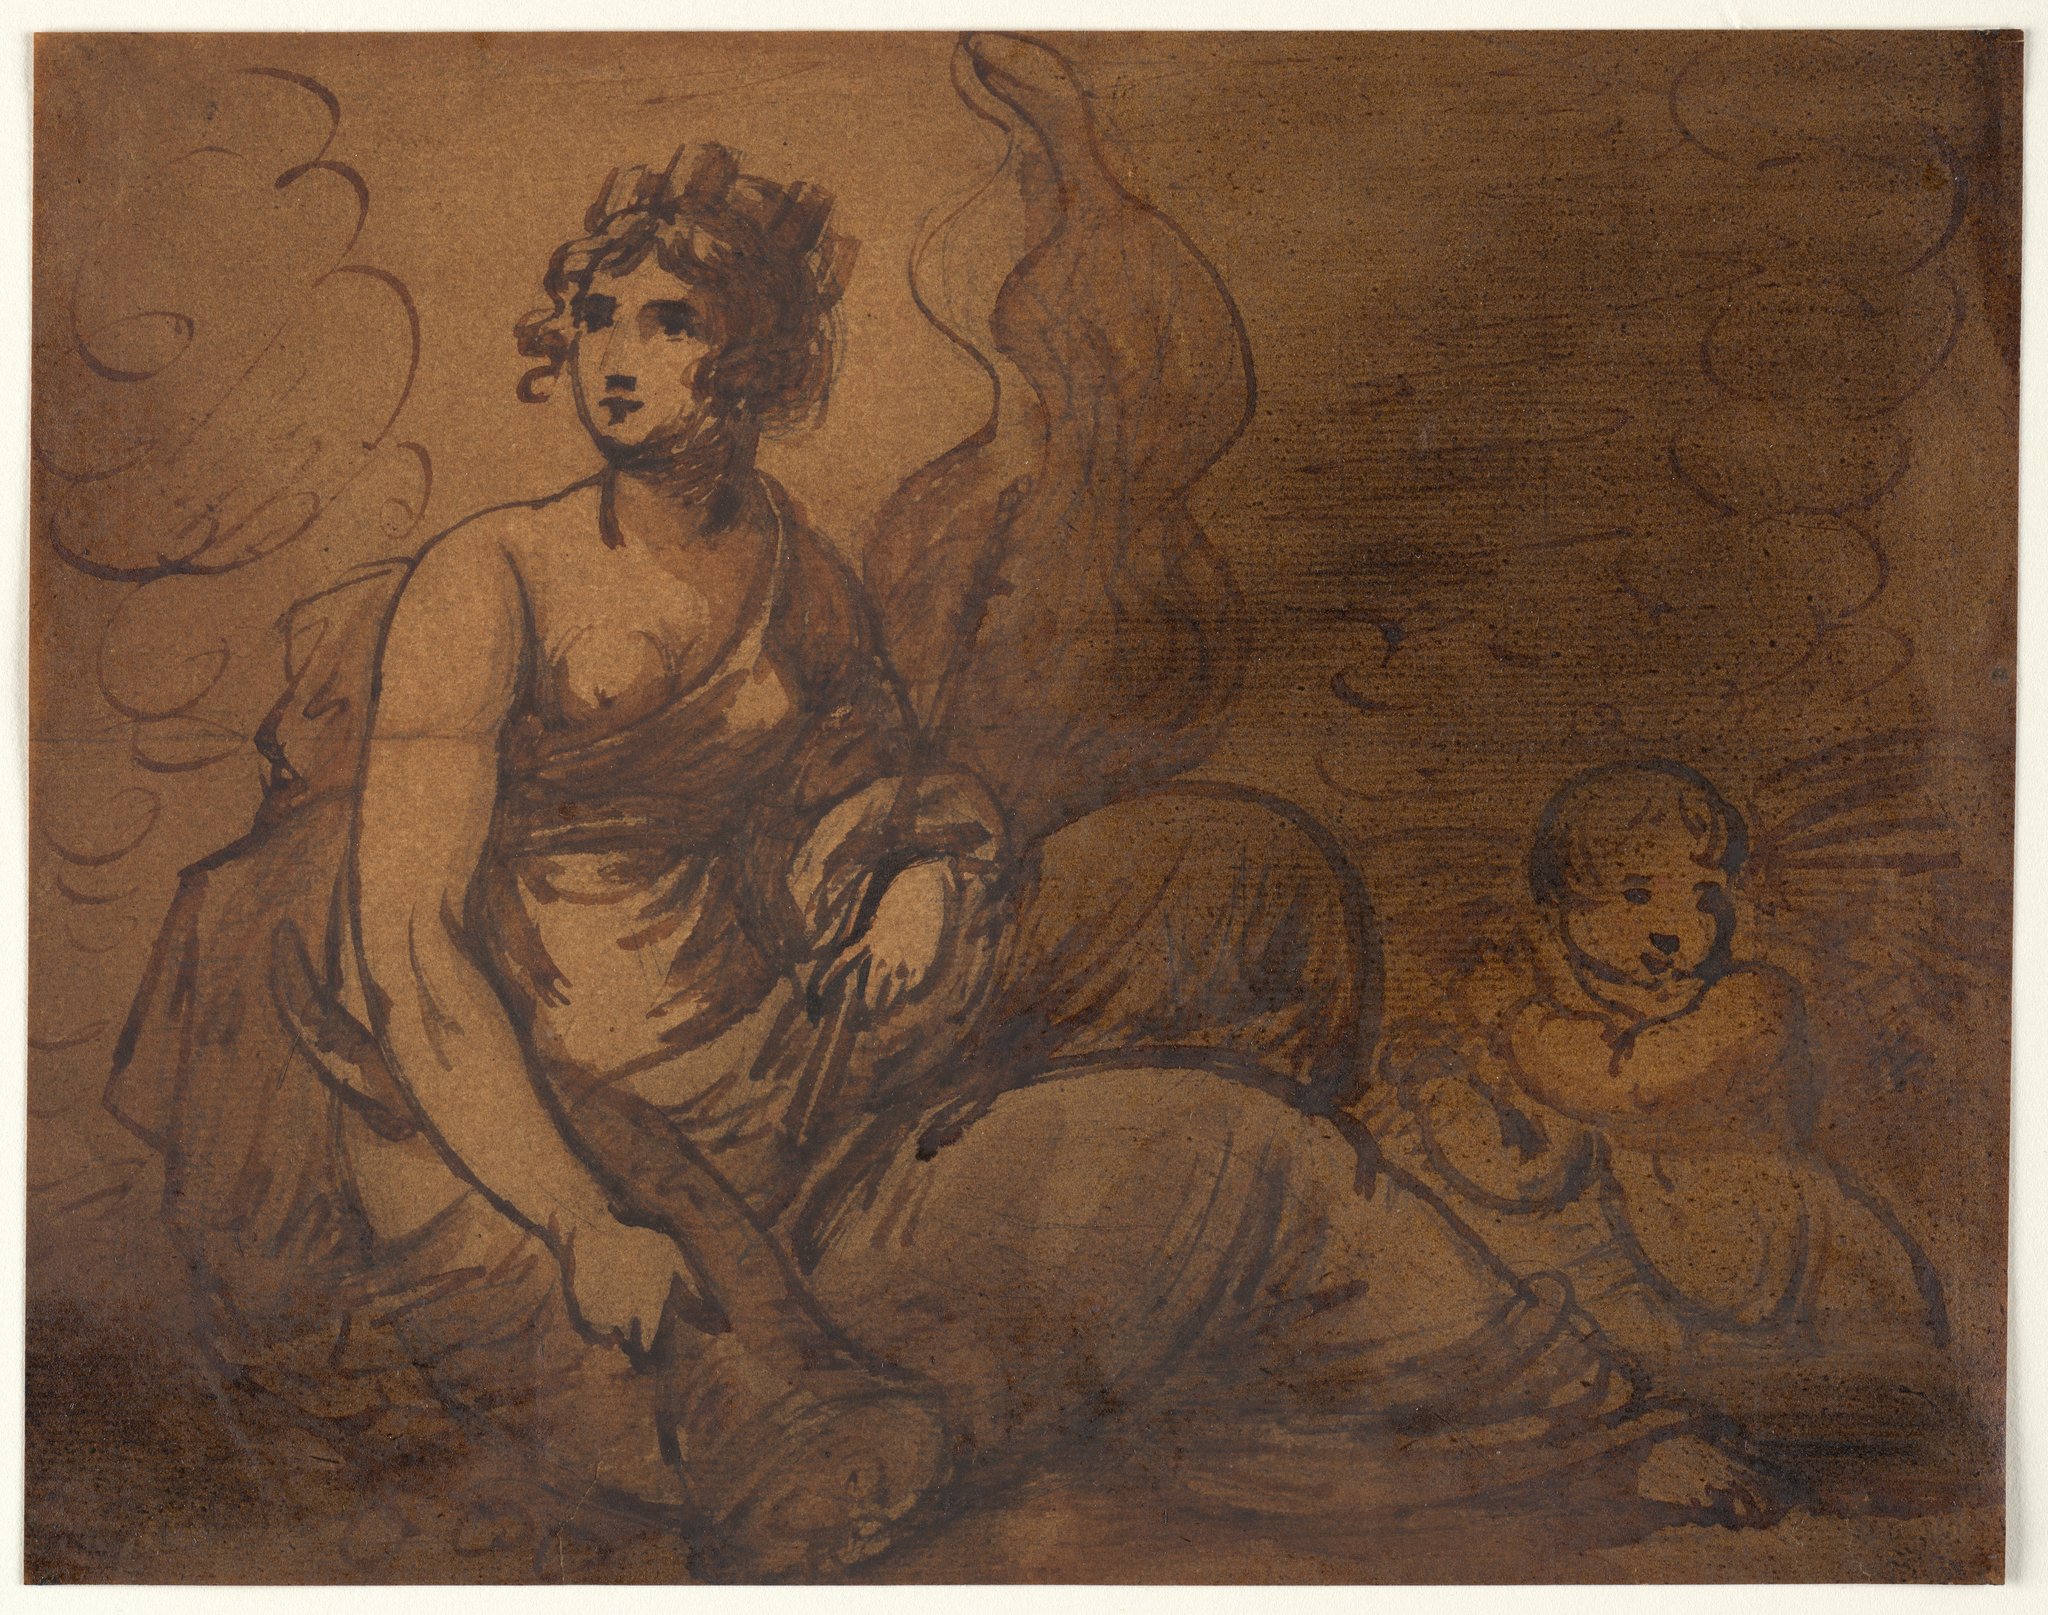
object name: drawing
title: Study of an Allegorical Female Figure with an Attendant Putto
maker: england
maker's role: artist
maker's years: 1700-1799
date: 1751-1800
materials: ink, pencil, varnish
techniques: brush, wash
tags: women,putti